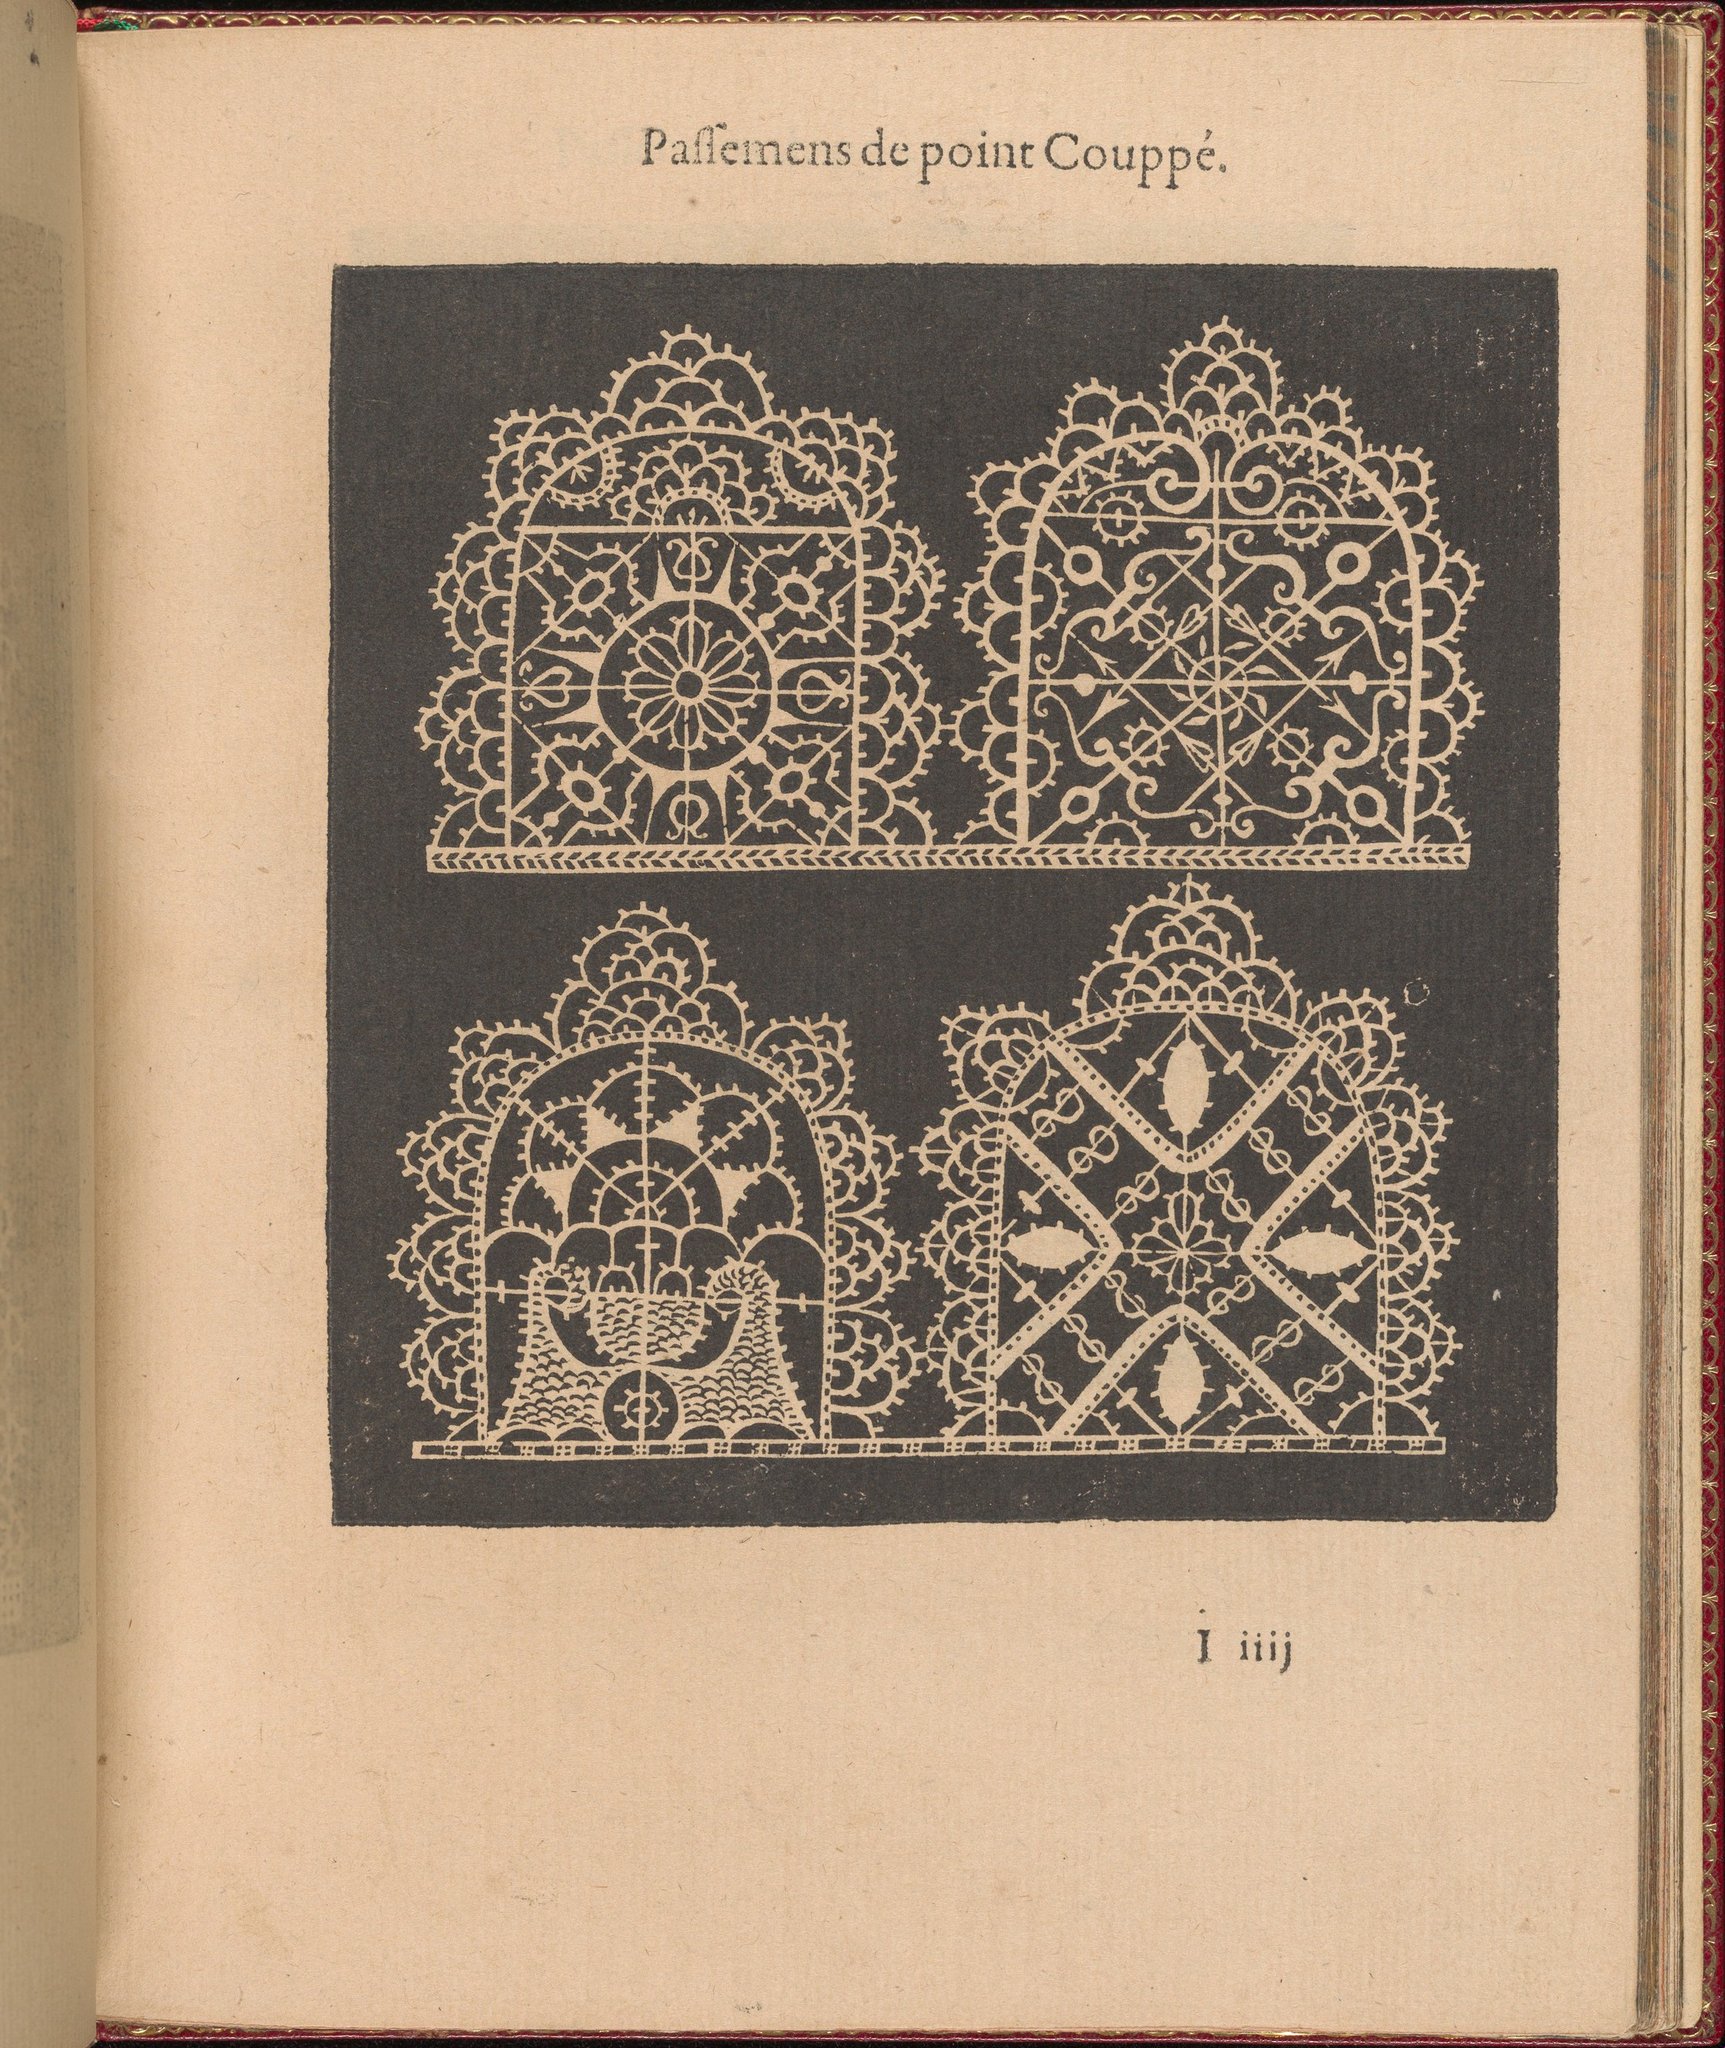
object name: book print ornament architecture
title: Les Singuliers et Nouveaux Portraicts... page 36 (recto)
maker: federico de vinciolo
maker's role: designer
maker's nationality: italian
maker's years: 1582-1599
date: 1588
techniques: woodcut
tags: flowers